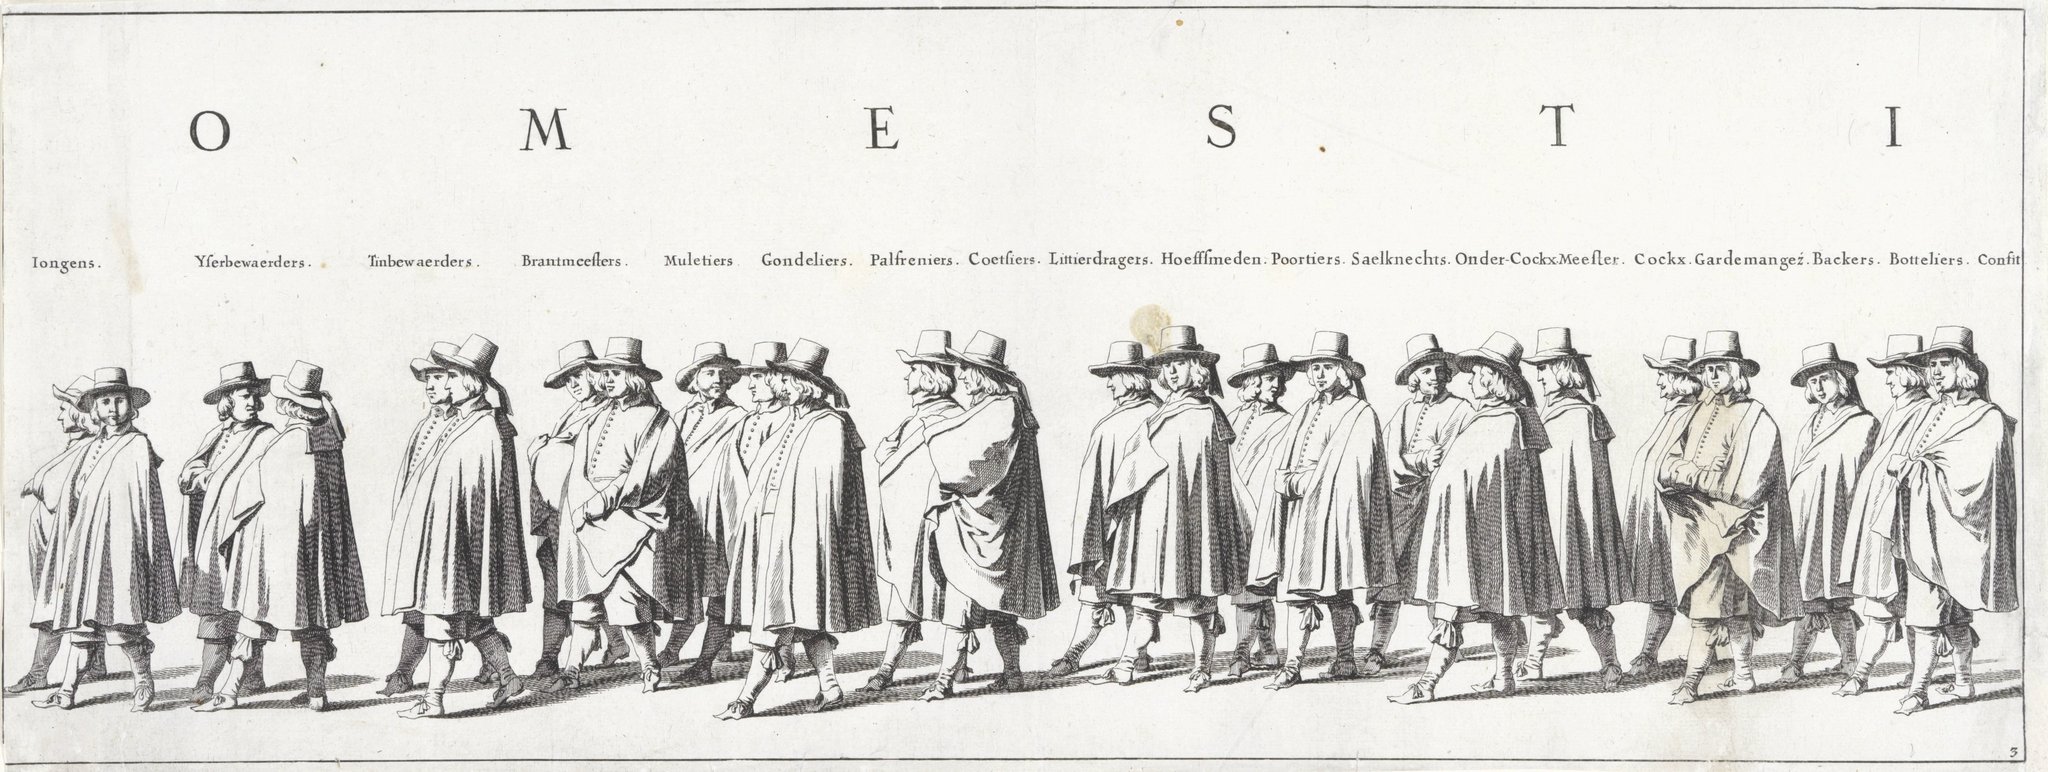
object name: print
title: De begrafenisstoet van stadhouder Frederik Hendrik te 's-Gravenhage in 1647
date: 1651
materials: paper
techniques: engraving, etching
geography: amsterdam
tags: cortege, funeral procession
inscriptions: collector's mark: Lugt 2228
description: De begrafenisstoet van stadhouder Frederik Hendrik te 's-Gravenhage op 10 mei 1647. Plaat nr. 3 met een deel van de stoet, boven de personen staat hun functie. Onderdeel van een serie van 30 platen en 20 tekstbladen, bedoeld om aan elkaar geplakt te worden.